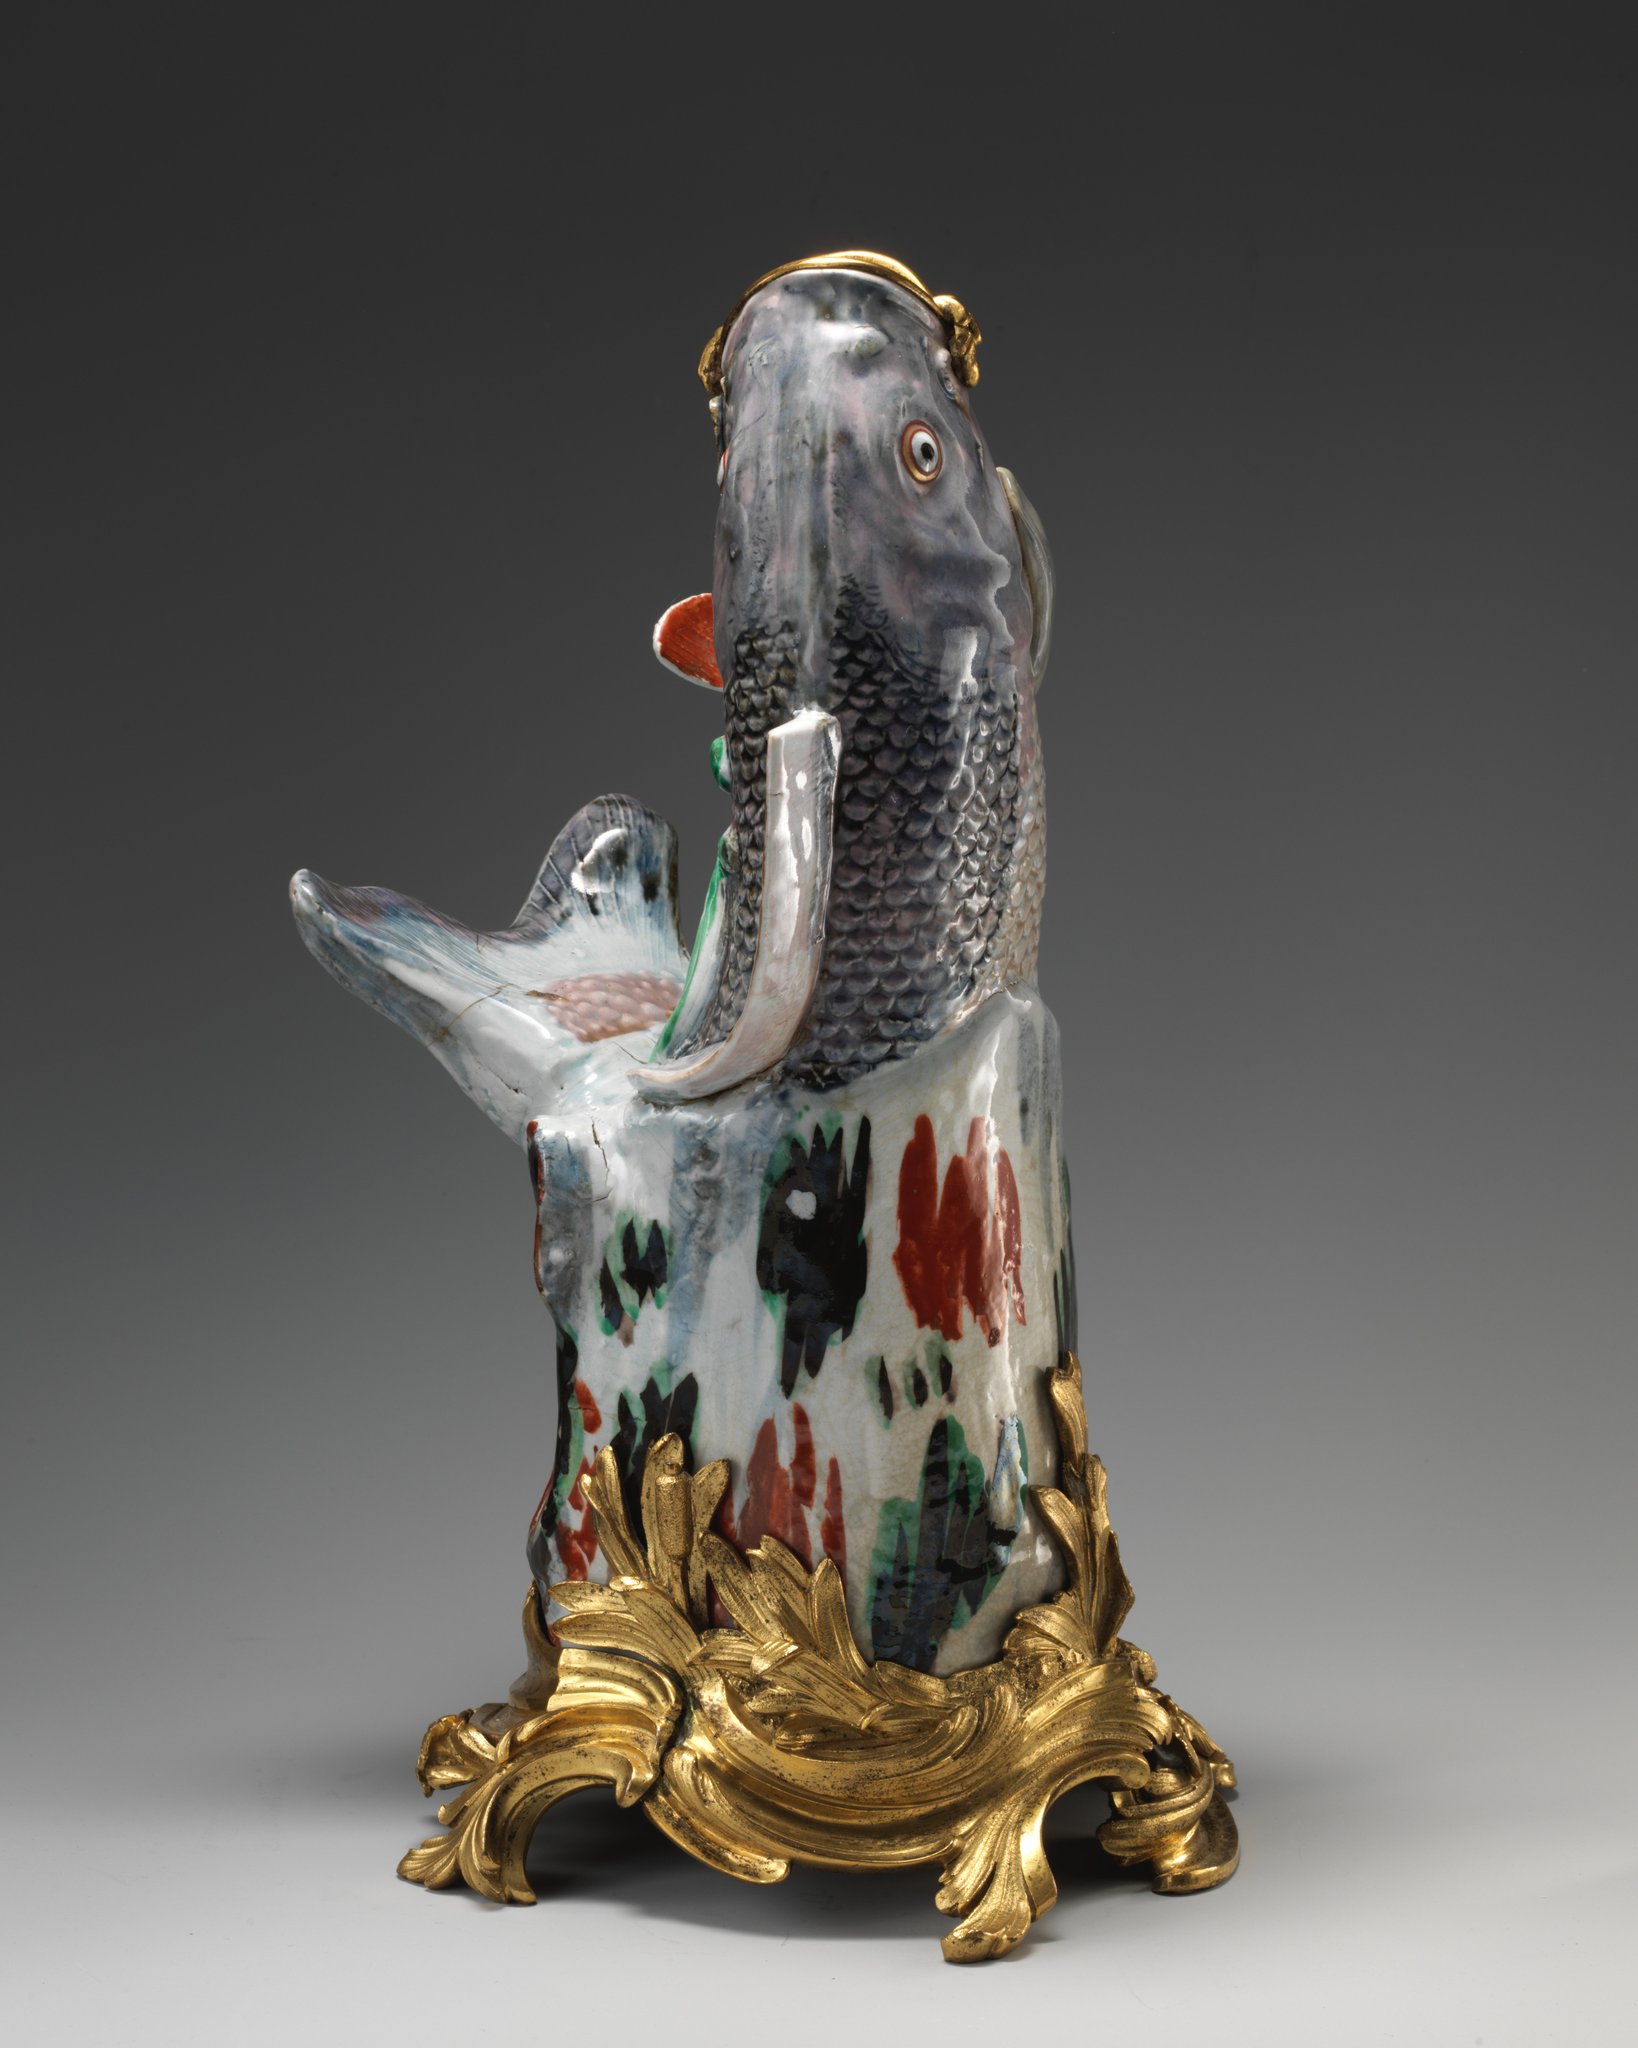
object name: vase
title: Carp in gilt-bronze mount (one of a pair)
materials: gilt bronze, hard paste porcelain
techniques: gilding